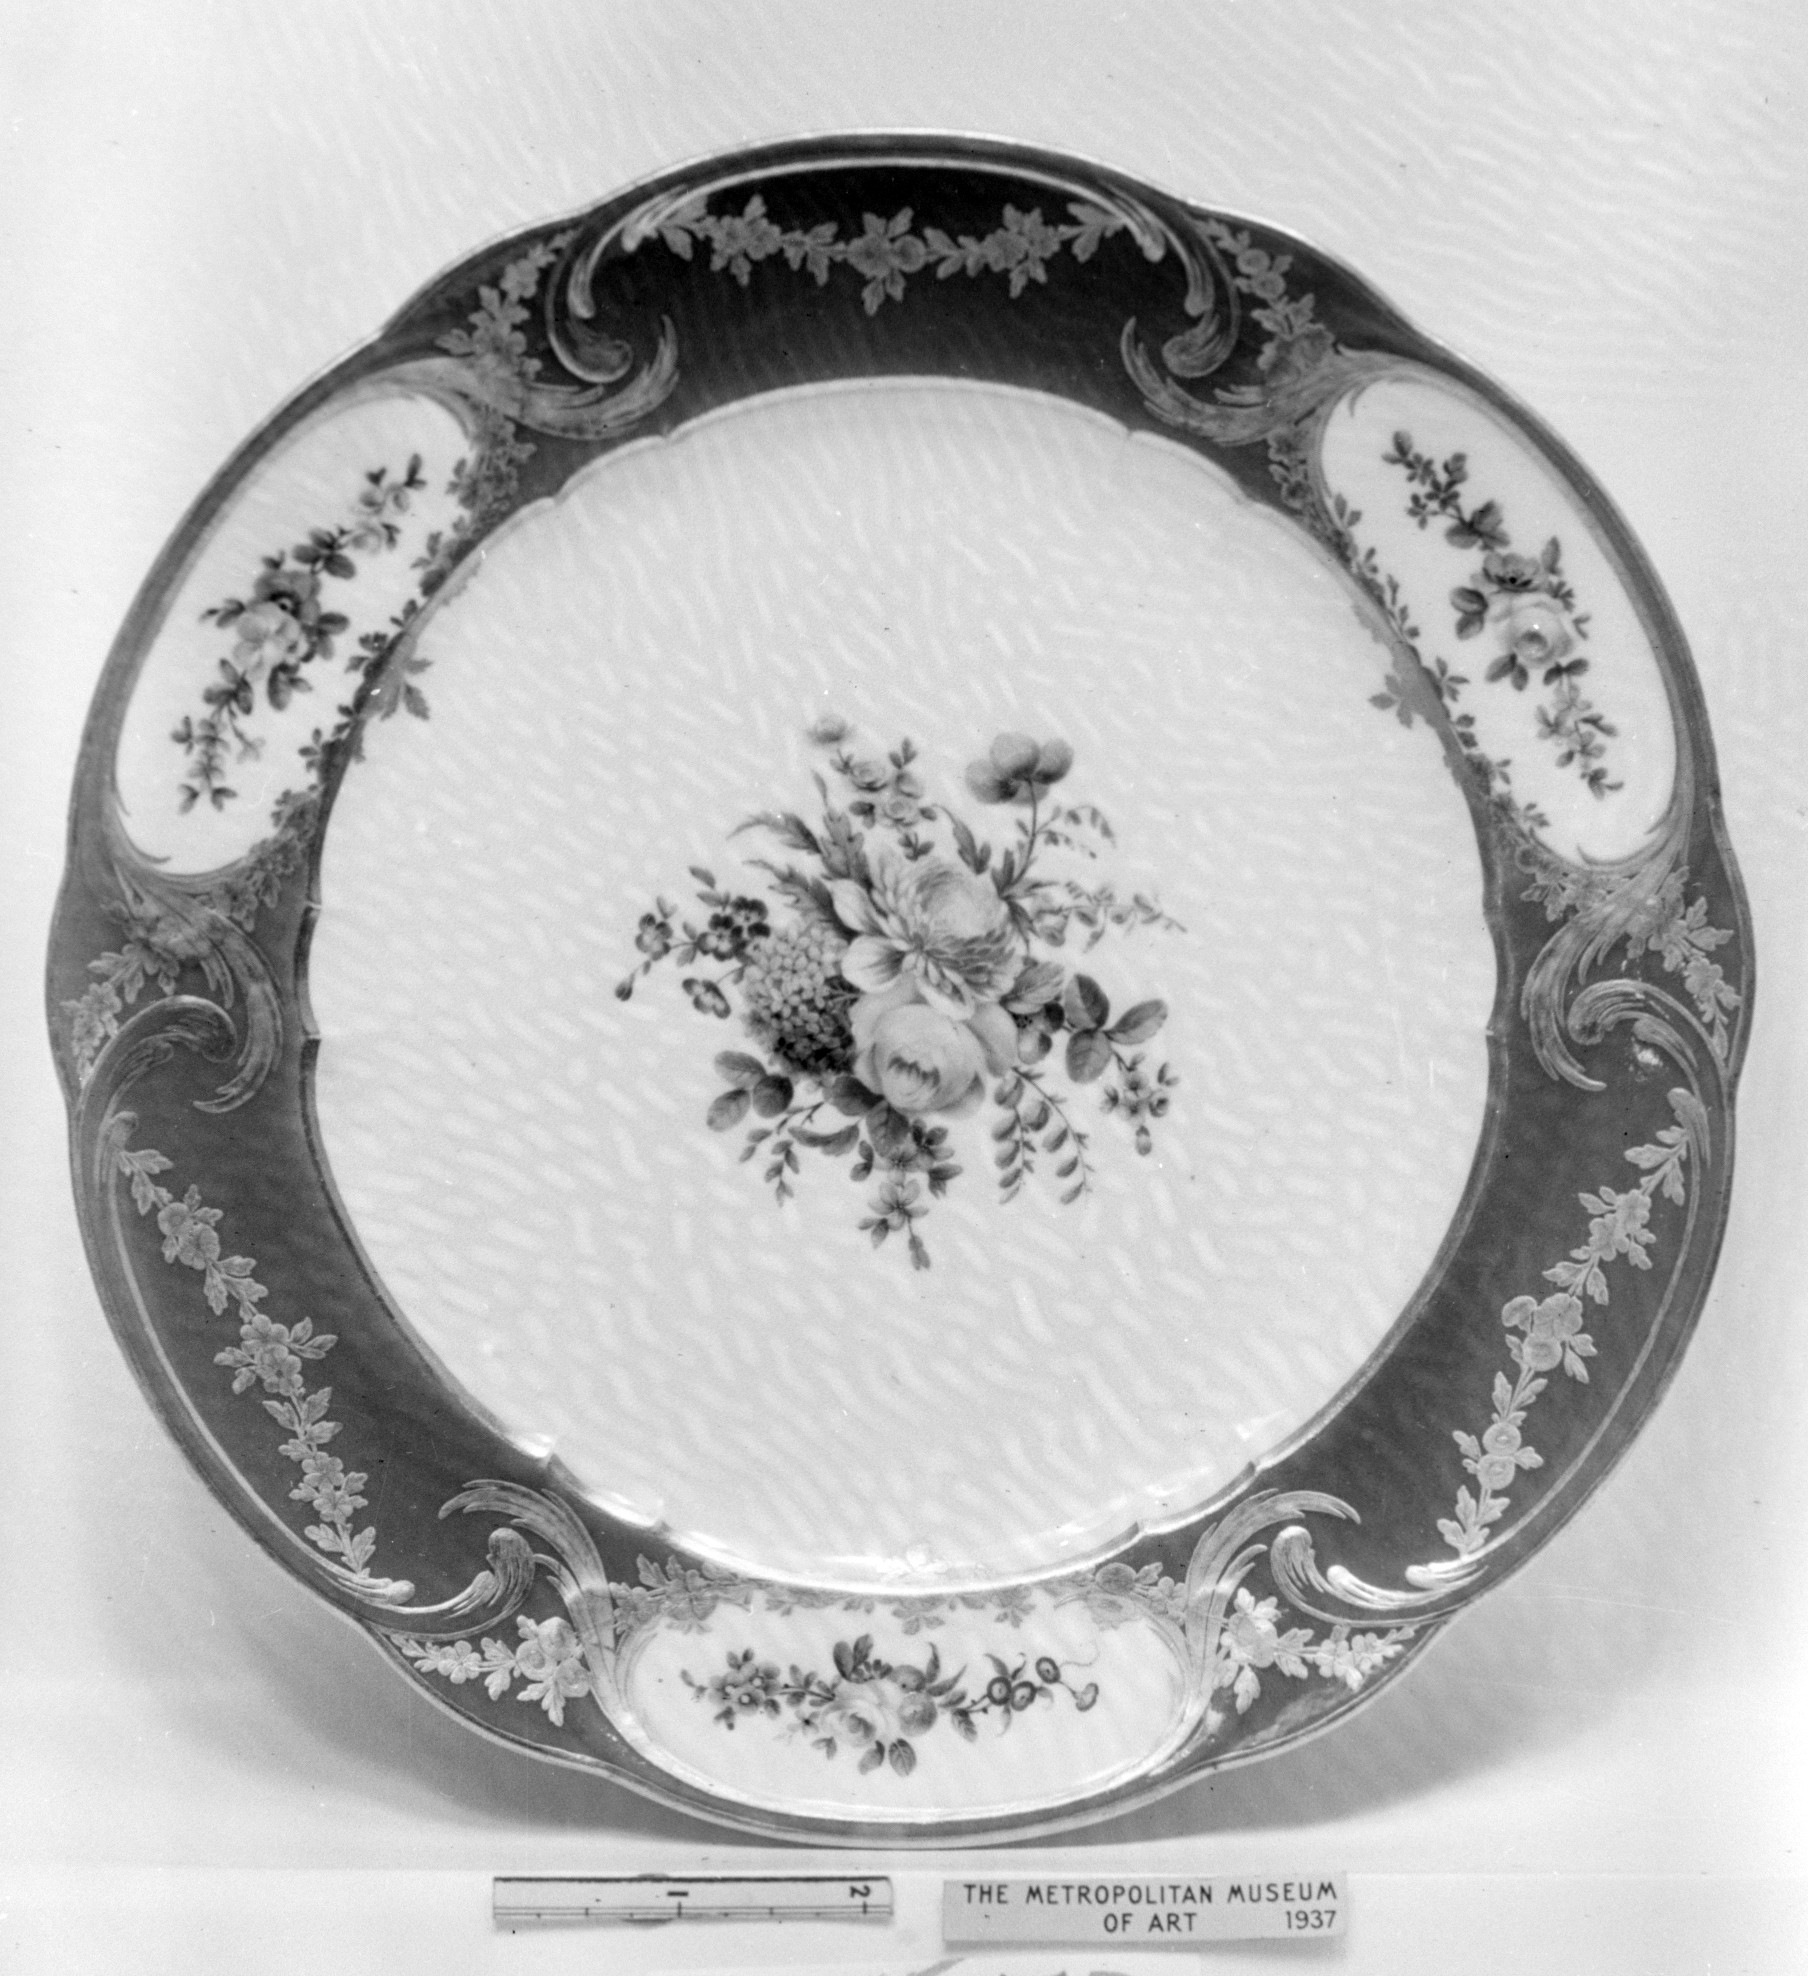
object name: plate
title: Plate (Assiette à palmes) (1 of 102) (part of a service)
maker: sèvres manufactory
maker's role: manufactory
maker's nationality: french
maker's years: 1740-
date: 1772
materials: soft paste porcelain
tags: garlands,flowers